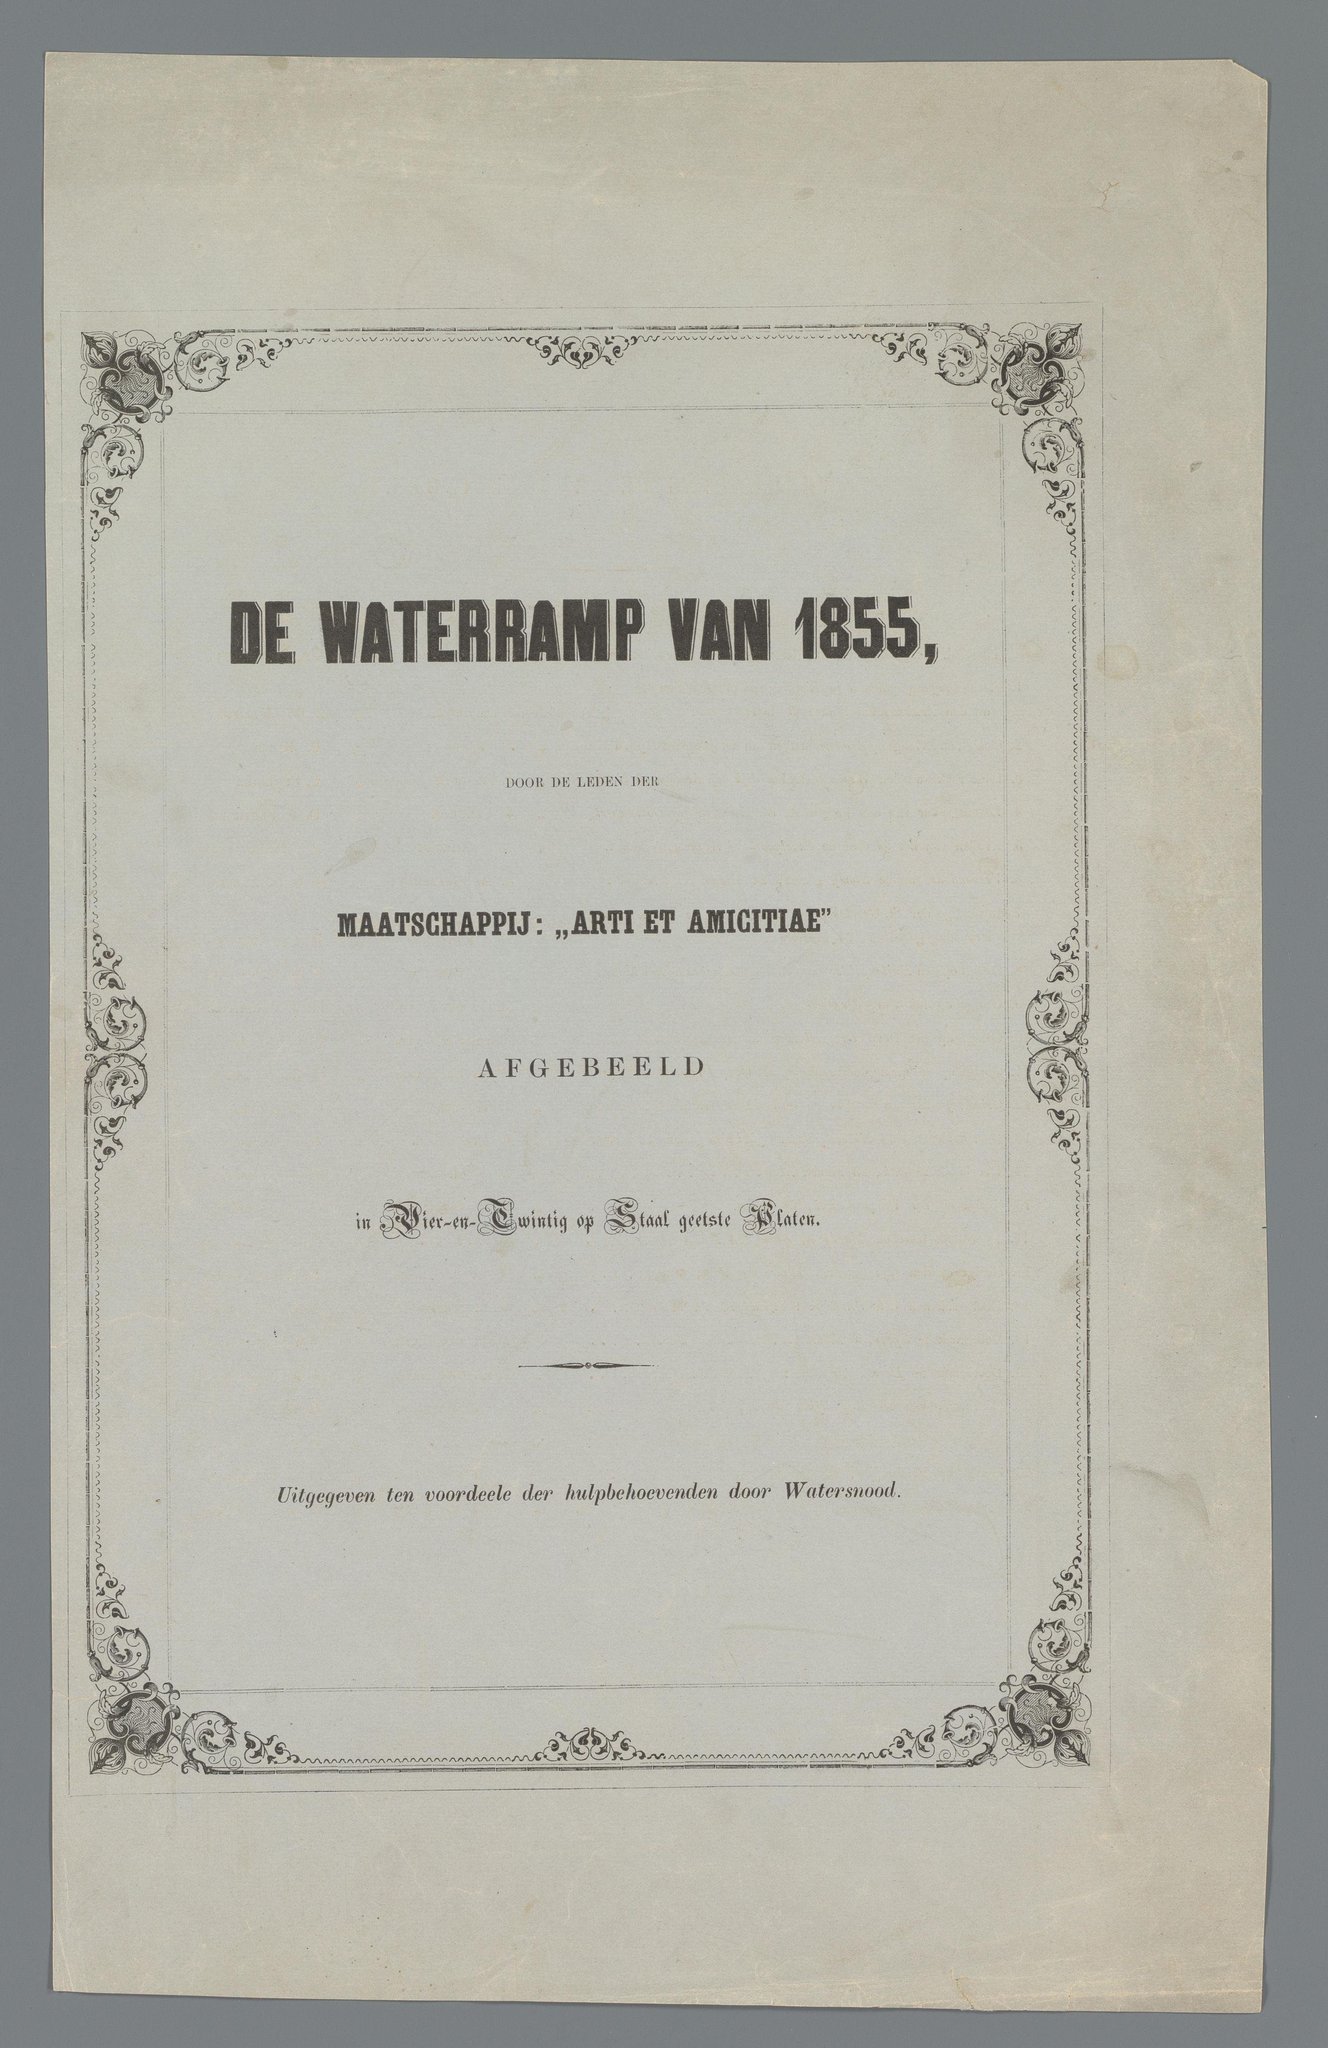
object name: titelblad, titelpagina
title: Titelpagina voor: De Waterramp van 1855, door de leden der maatschappij 'Arti et Amicitiae' afgebeeld in Vier-en Twintig op Staal geetste Platen, 1855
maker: Anonymous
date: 1855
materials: paper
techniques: letterpress printing, engraving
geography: amsterdam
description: Op verso een lijst van de vierentwintig prenten met naam van de makers en titels, zie ook RP-P-OB-89.128-25. Uitgegeven ten behoeve van de slachtoffers van de watersnood. Titelpagina voor: De Waterramp van 1855, door de leden der maatschappij 'Arti et Amicitiae' afgebeeld in Vier-en Twintig op Staal geetste Platen, 1855